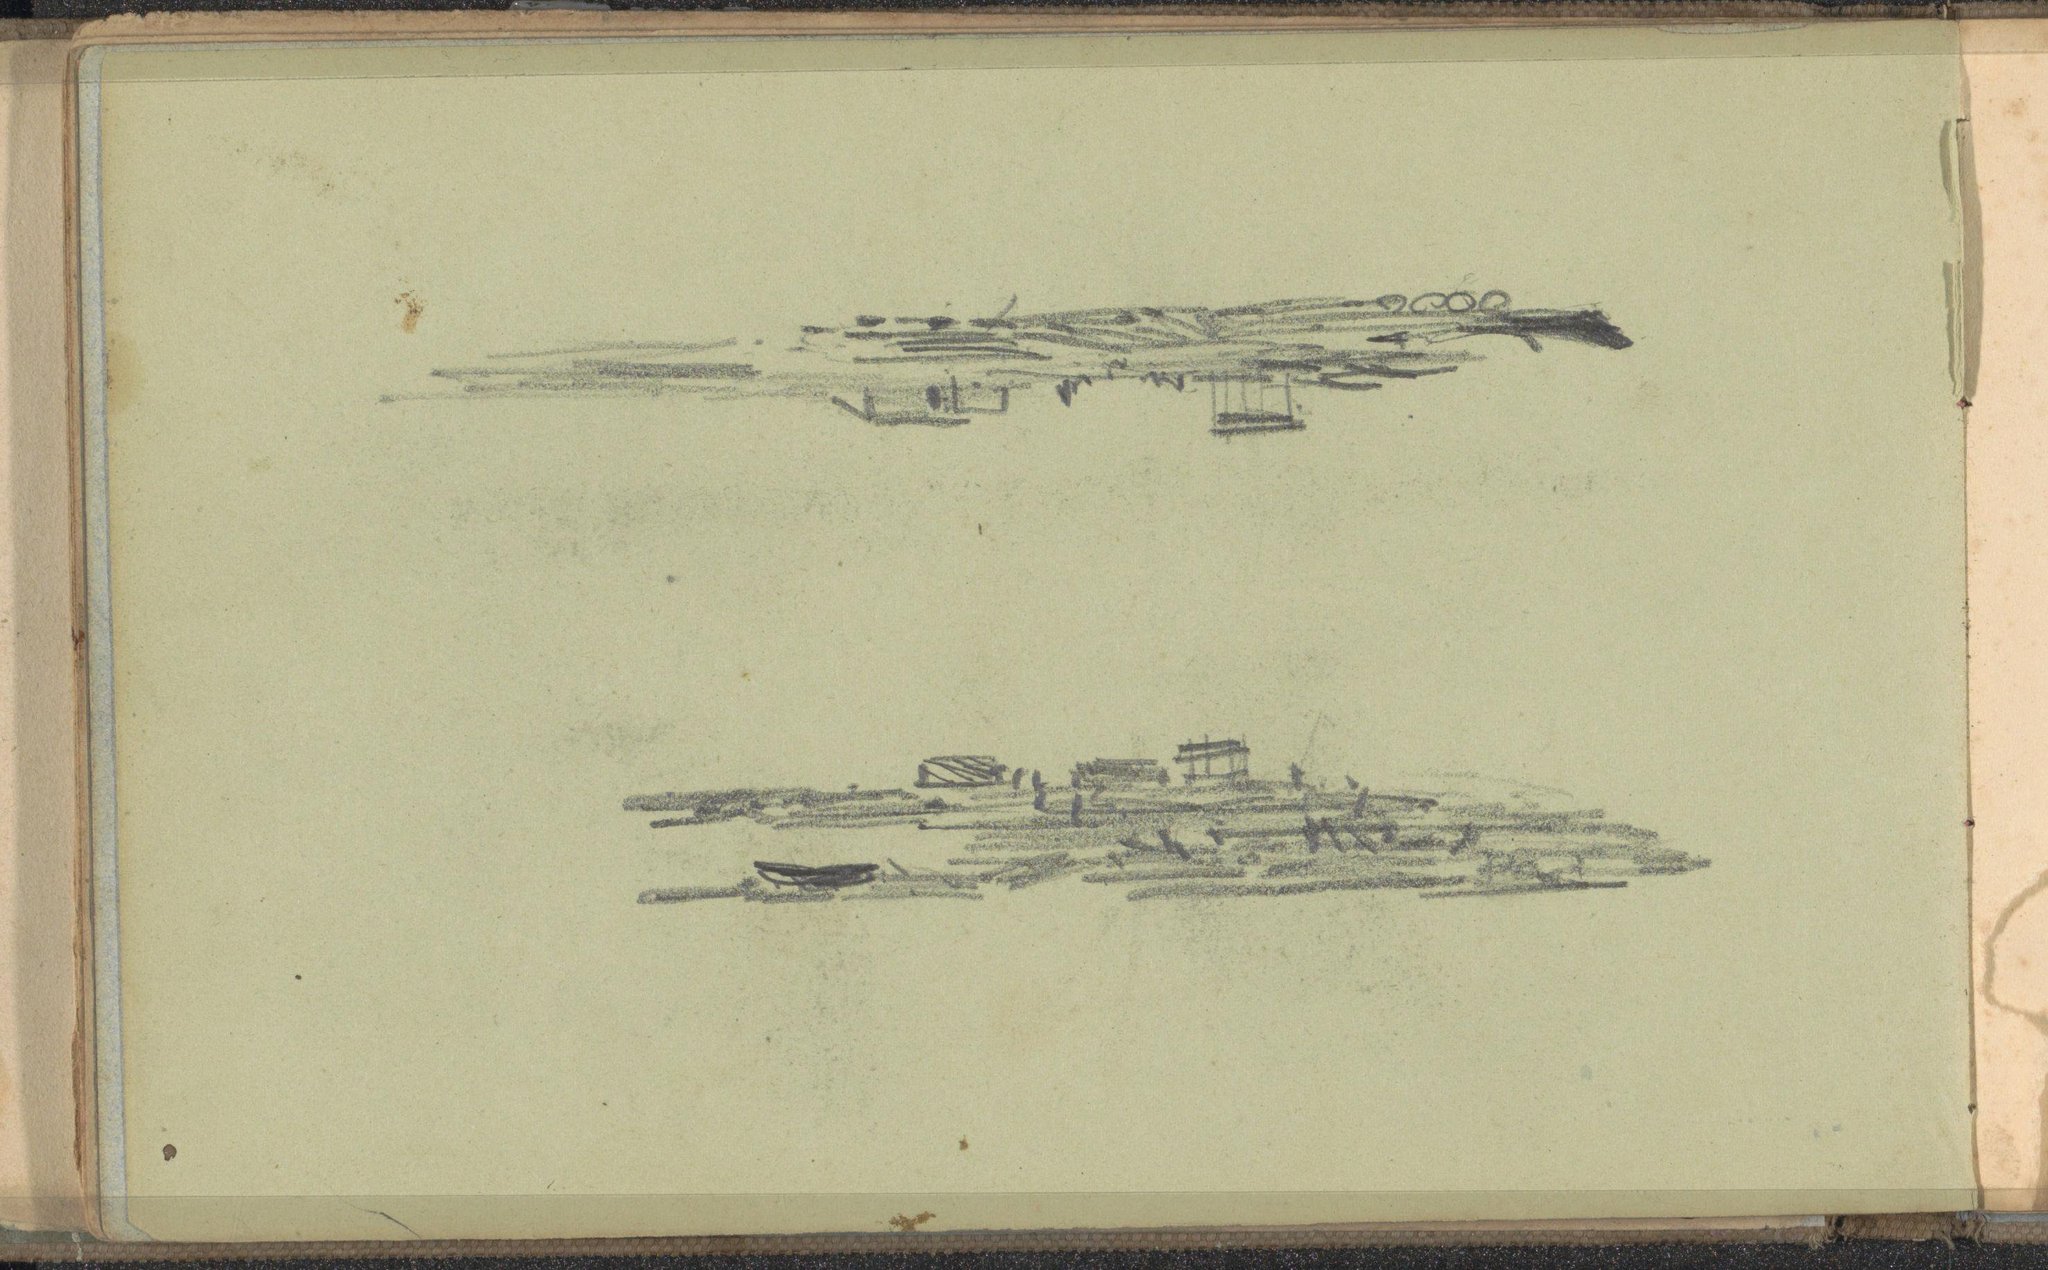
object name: sketchbook leaf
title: Zeilschepen en een landschap met bebouwing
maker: louis apol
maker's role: draughtsman, painter, print maker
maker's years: 1850-1936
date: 1880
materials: paper, pencil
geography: norway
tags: landscapes, ships (in general), civic architecture; edifices; dwellings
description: Blad 28 recto uit een schetsboek met 38 bladen betekend tijdens de expeditie naar Nova Zembla in 1880.